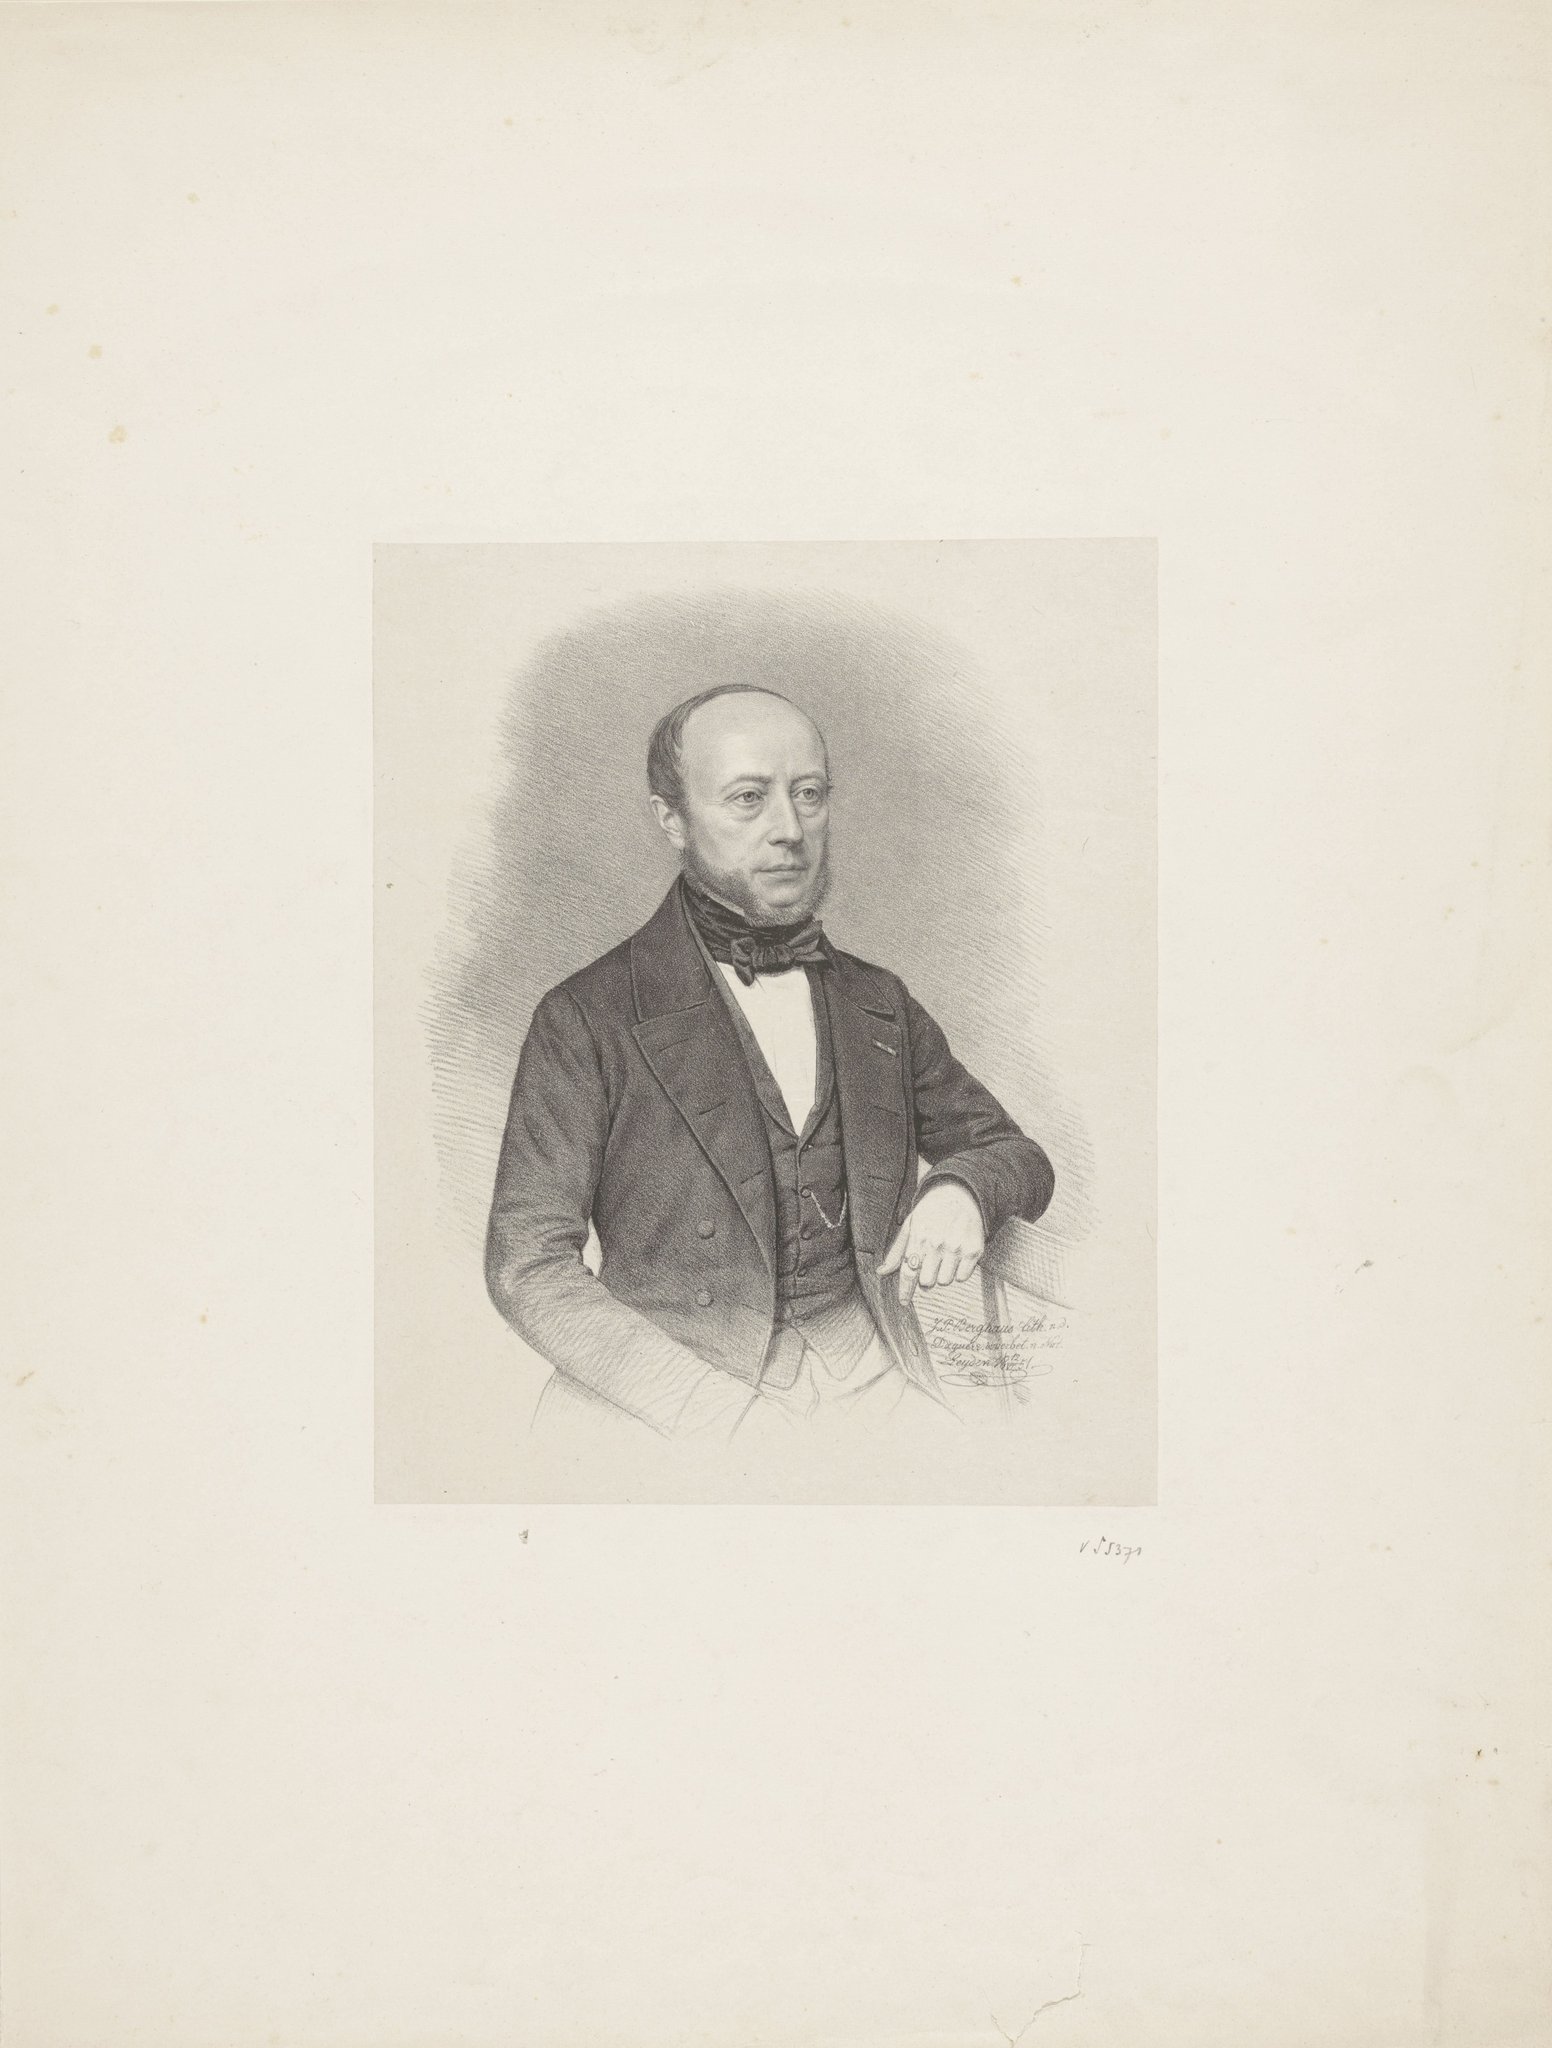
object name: print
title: Portret van Duco Johannes Storm Buysing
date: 1851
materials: paper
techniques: lithograph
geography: leiden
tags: the hague, engineer, knighthood order, historical persons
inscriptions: collector's mark: Lugt 2228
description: De geportretteerde zit en leunt met zijn rechterarm op de grug van een stoel. Op zijn borst draagt hij een ridderorde.